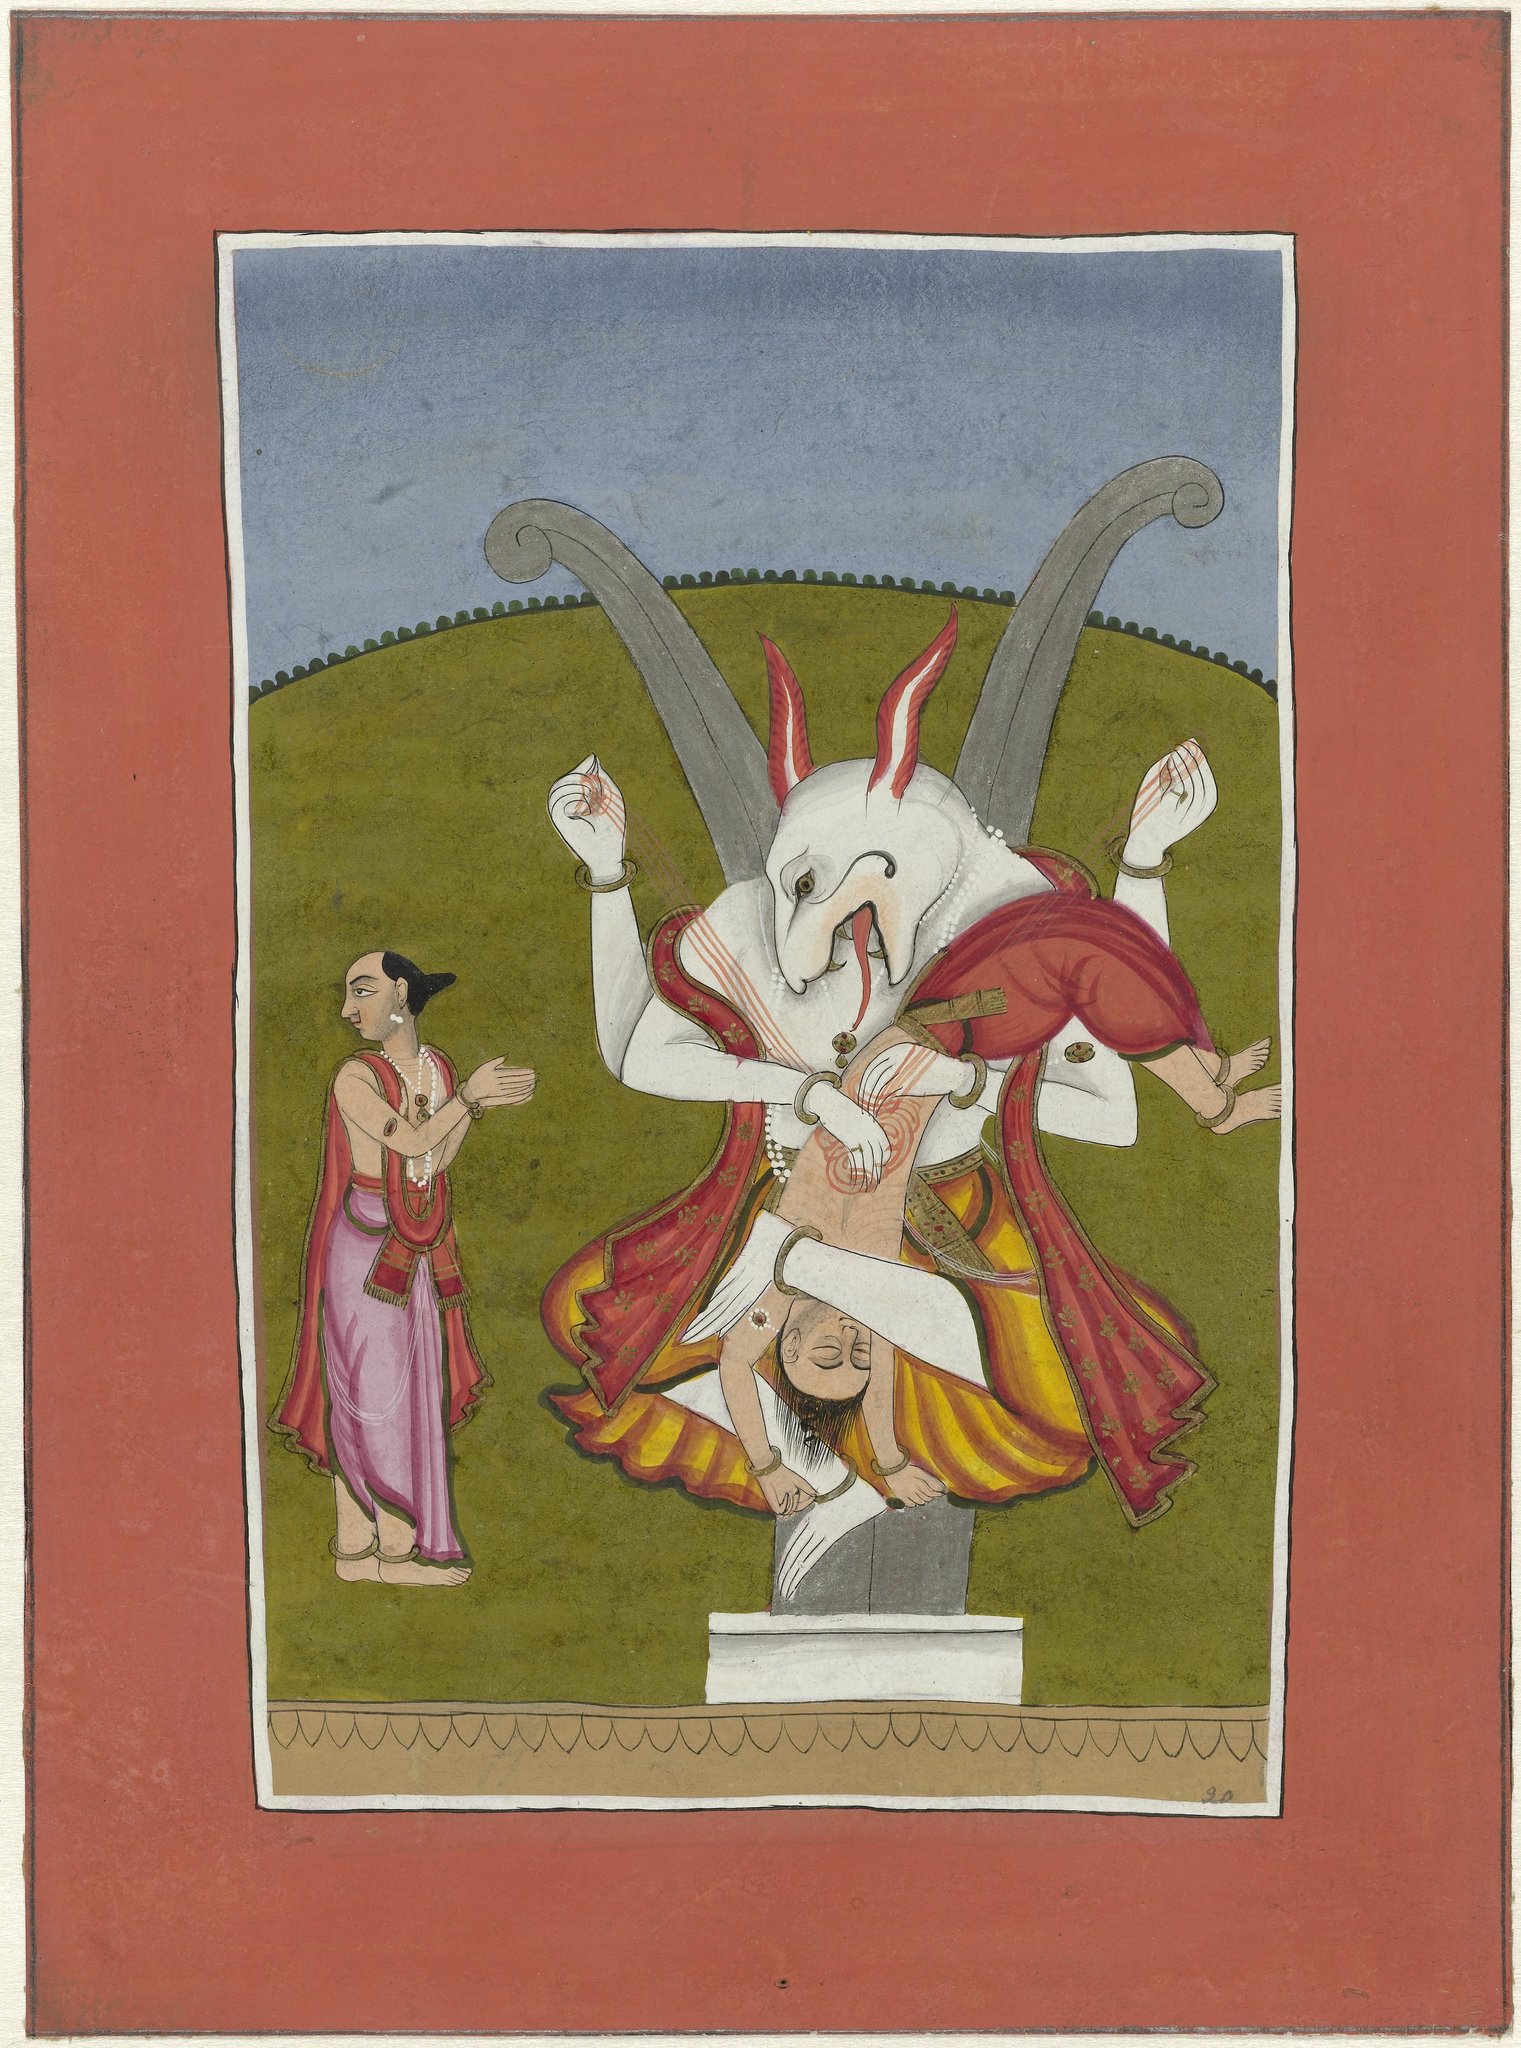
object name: indian miniature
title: Narasimha (incarnatie van Vishnu als man-leeuw)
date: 1825-1875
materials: paper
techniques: brush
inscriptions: inscription: ‘4 Lion-man // Narasimha avatara’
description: Vishnu in de gedaante van de man-leeuw (Narasimha) komt uit een pilaar van het paleis naar boven en buiten om de demon Hiranyakashipu te verslaan. Rechts van hem staat een jonge man, de prins Prahlada. De voorstelling is omlijst door een smal wit biesje, daaromheen een brede oranjerode sierrand met zwarte kaderlijnen; dit blad is op een blad kardoespapier opgeplakt waarop een zwarte kaderlijn in potlood is getekend.